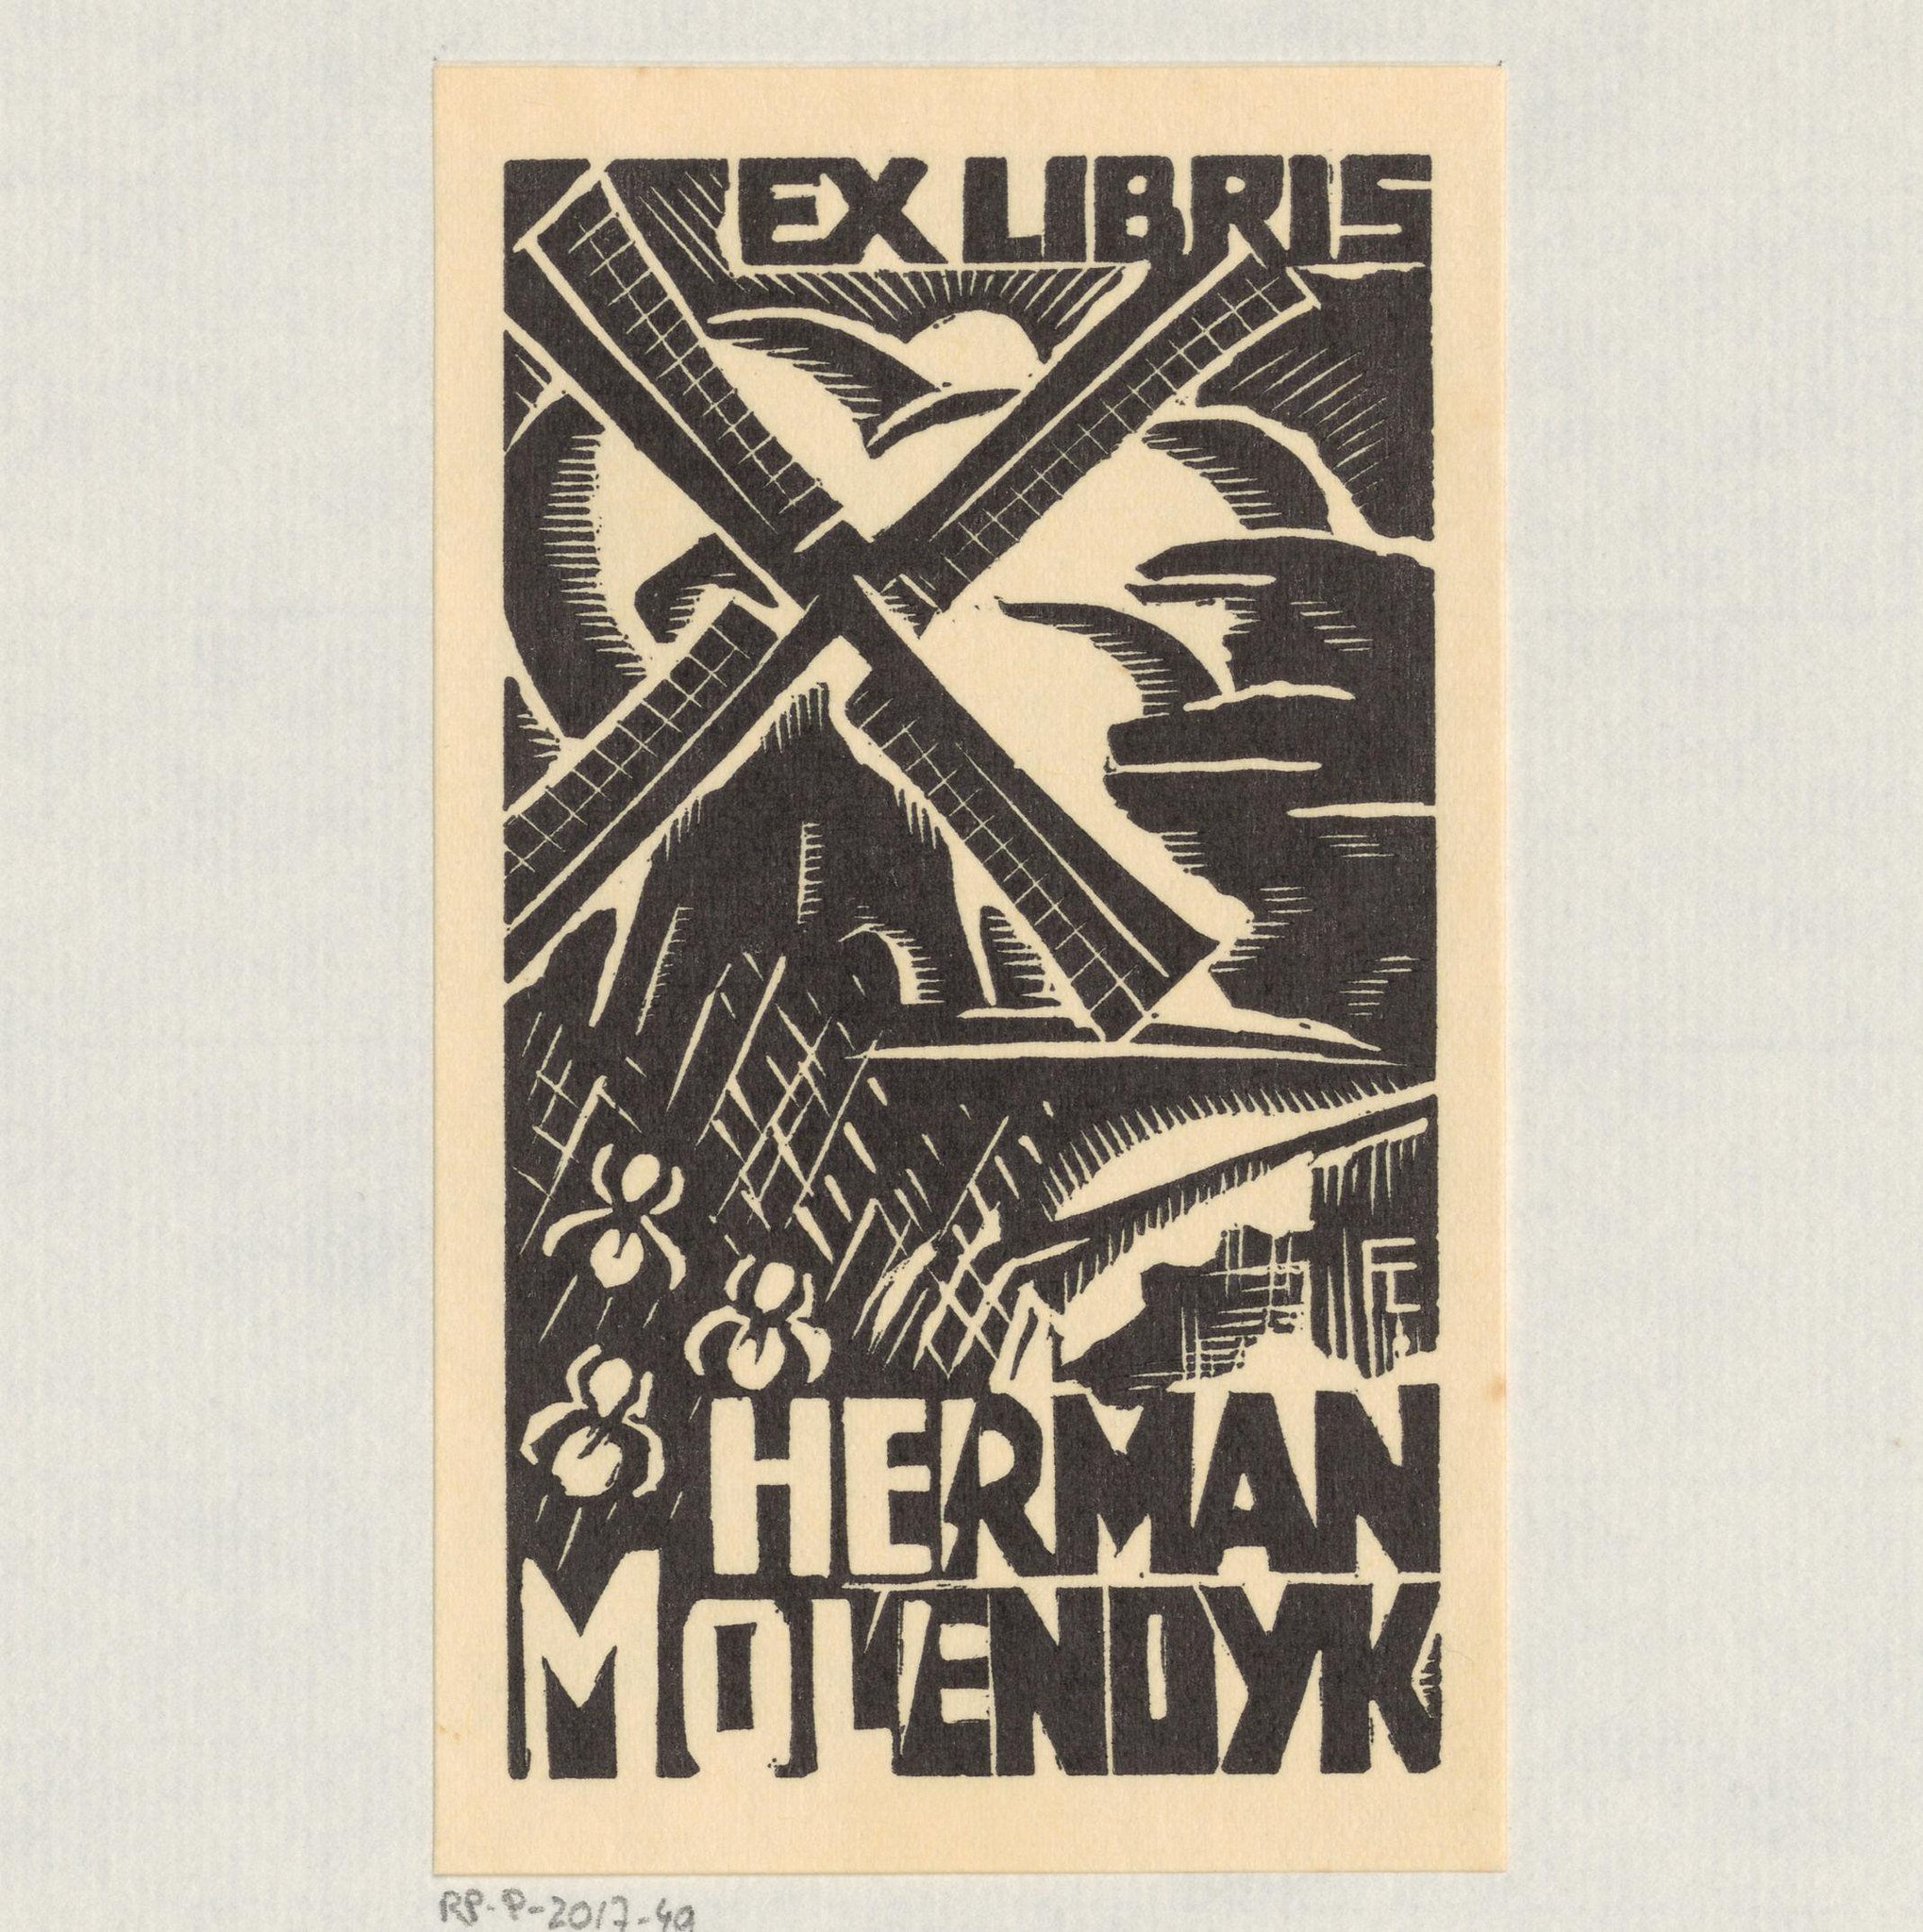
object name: bookplate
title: Ex libris van Herman Molendijk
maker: fré cohen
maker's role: draughtsman, print maker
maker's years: 1903-1943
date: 1935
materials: paper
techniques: woodcut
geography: netherlands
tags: windmill